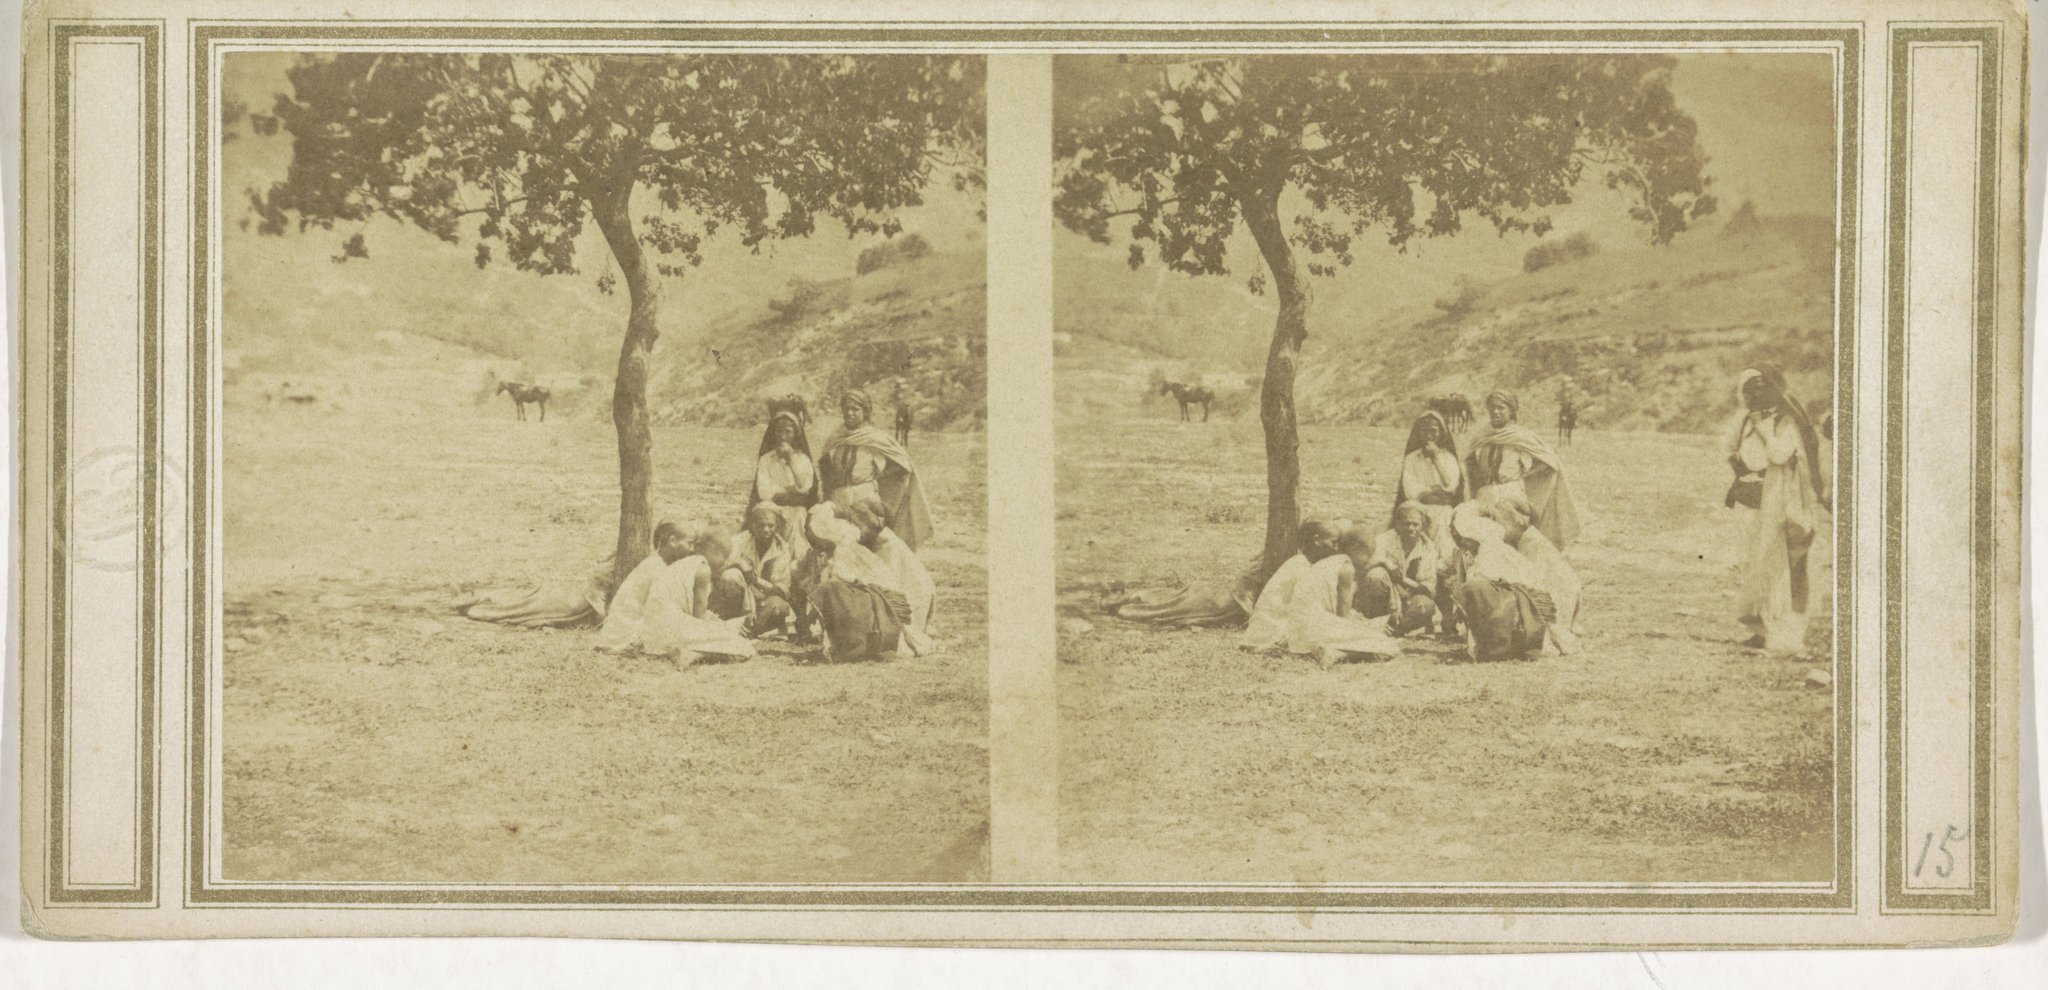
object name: stereograph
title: Arabieren spelen kaart, Algerije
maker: pierre-ambroise richebourg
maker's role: fotograaf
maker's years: 1810-1875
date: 1850-1870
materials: photographic support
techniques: albumen print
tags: algerije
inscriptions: check stamp: ‘monogram LM’, number: ‘340’, title: ‘Arabes jouarit aux Cartes Algérié’, number: ‘15’